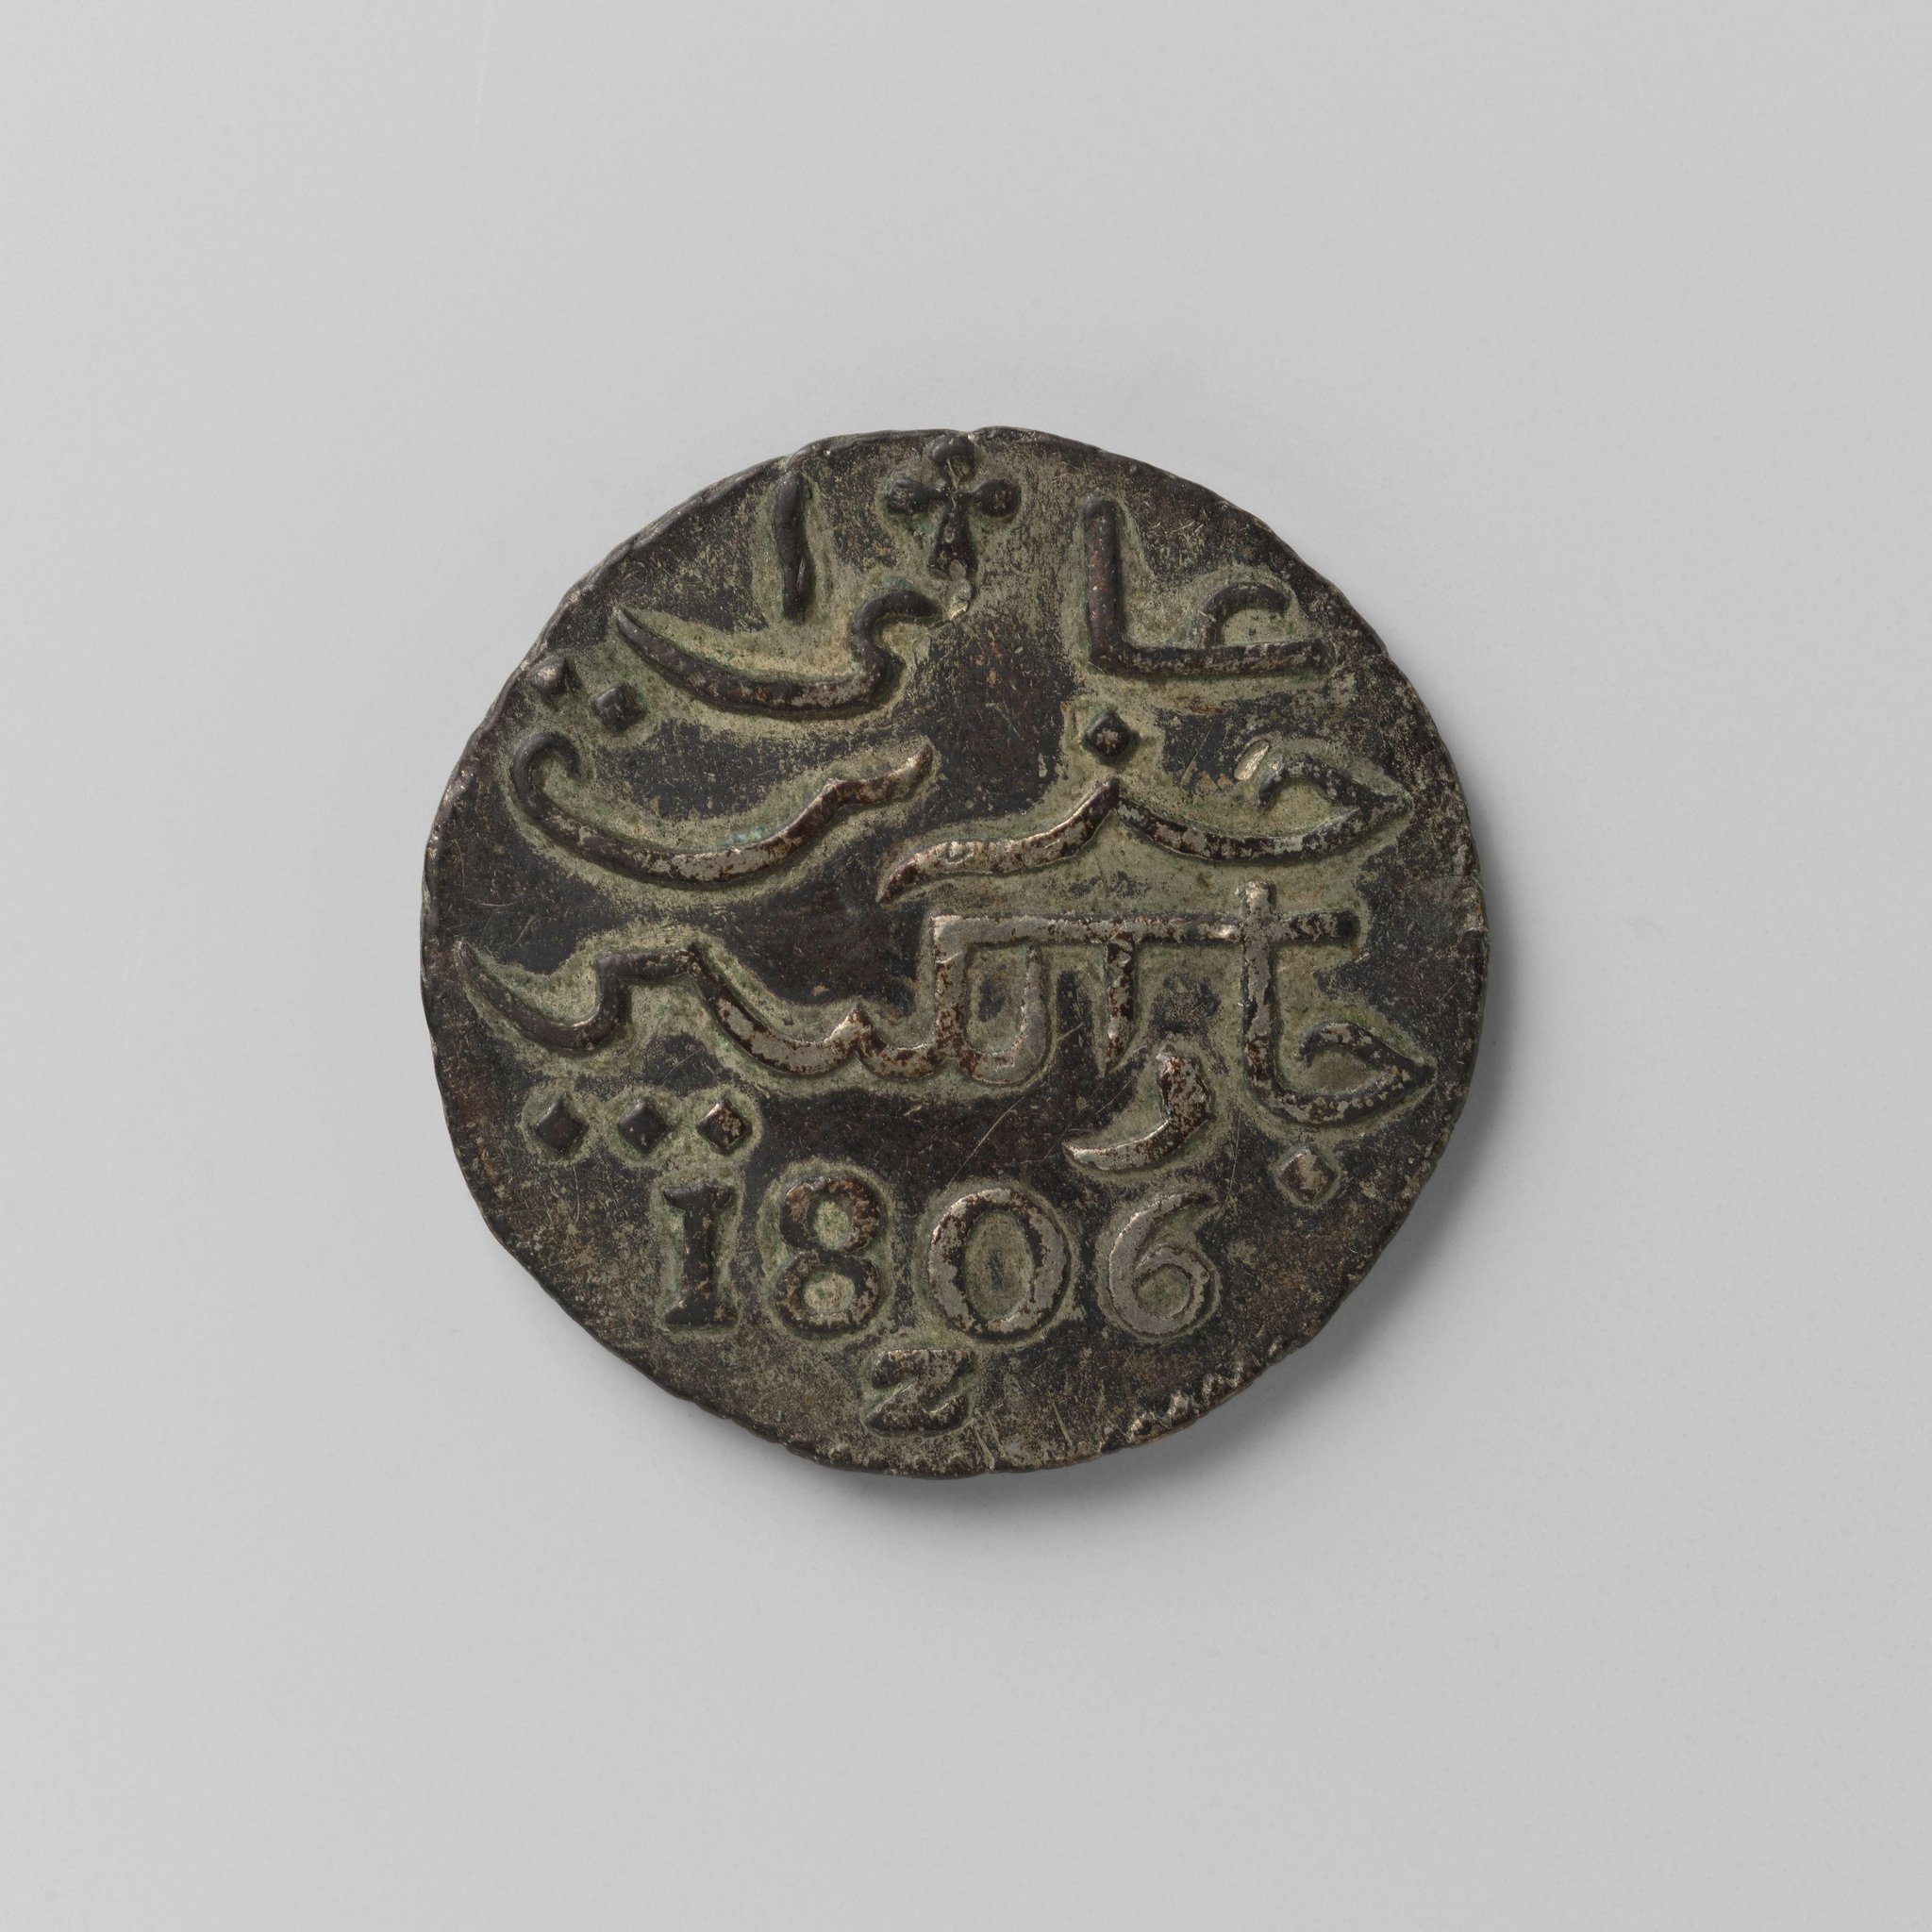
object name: halve ropij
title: Halve zilveren ropij van Nederlands Indië uit Java, 1806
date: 1806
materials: silver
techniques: striking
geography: batavia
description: Zilveren munt. Voorzijde: drieregelig opschrift in Arabische letters. Daarboven muntteken en daaronder jaartal, waaronder muntmeesterteken. Keerzijde: vierregelig opschrift in Arabische letters. Kabelrand.